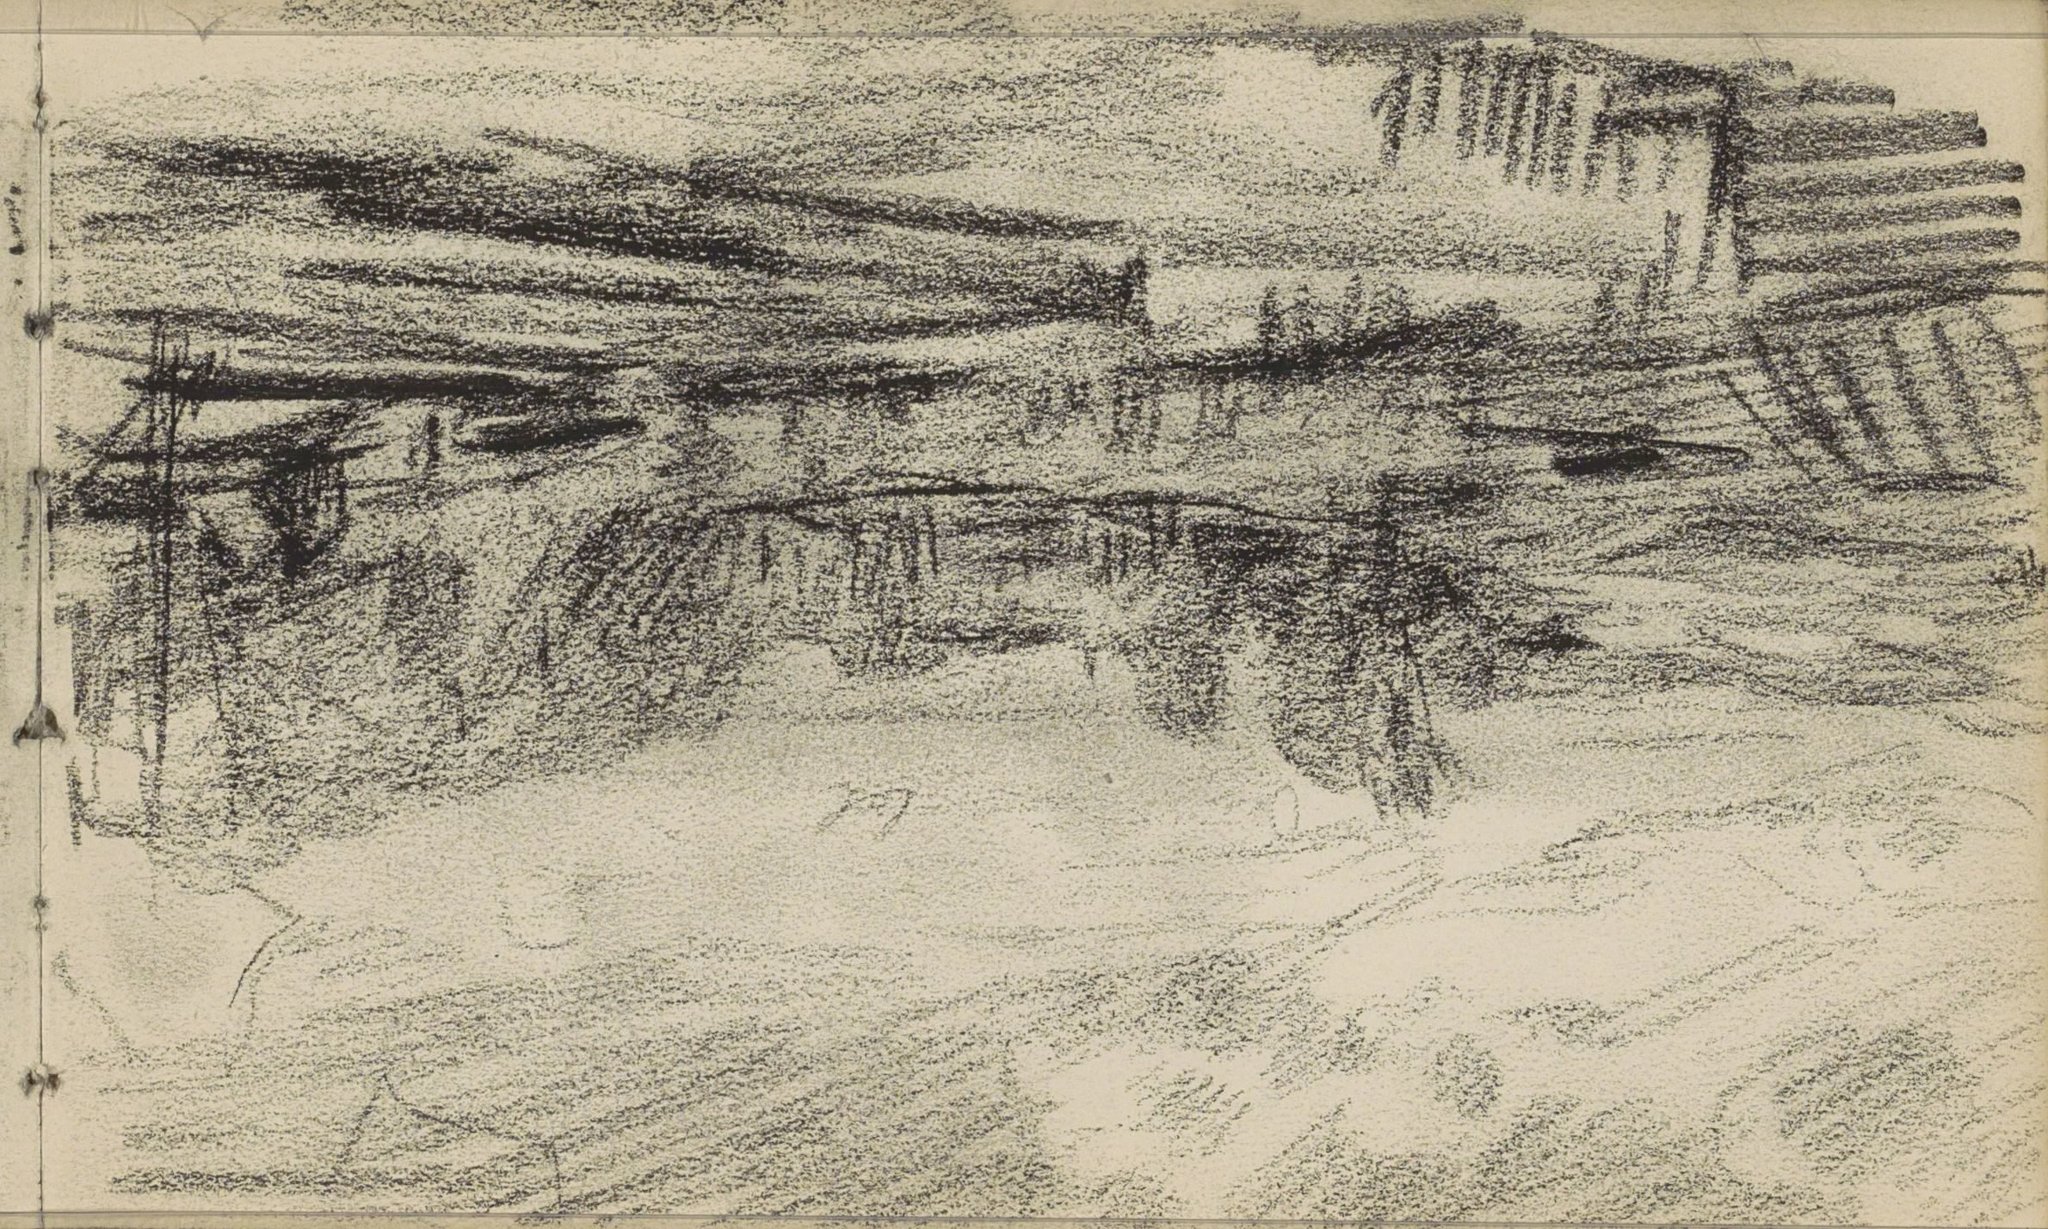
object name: sketchbook leaf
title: Landschap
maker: johan antonie de jonge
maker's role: draughtsman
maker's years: 1864-1927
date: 1901-1927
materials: chalk, paper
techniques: stumping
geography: south holland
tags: landscapes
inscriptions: kleurnotitie, handgeschreven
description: Landschap, mogelijk met water. Blad 4 uit een schetsboek met 45 bladen.